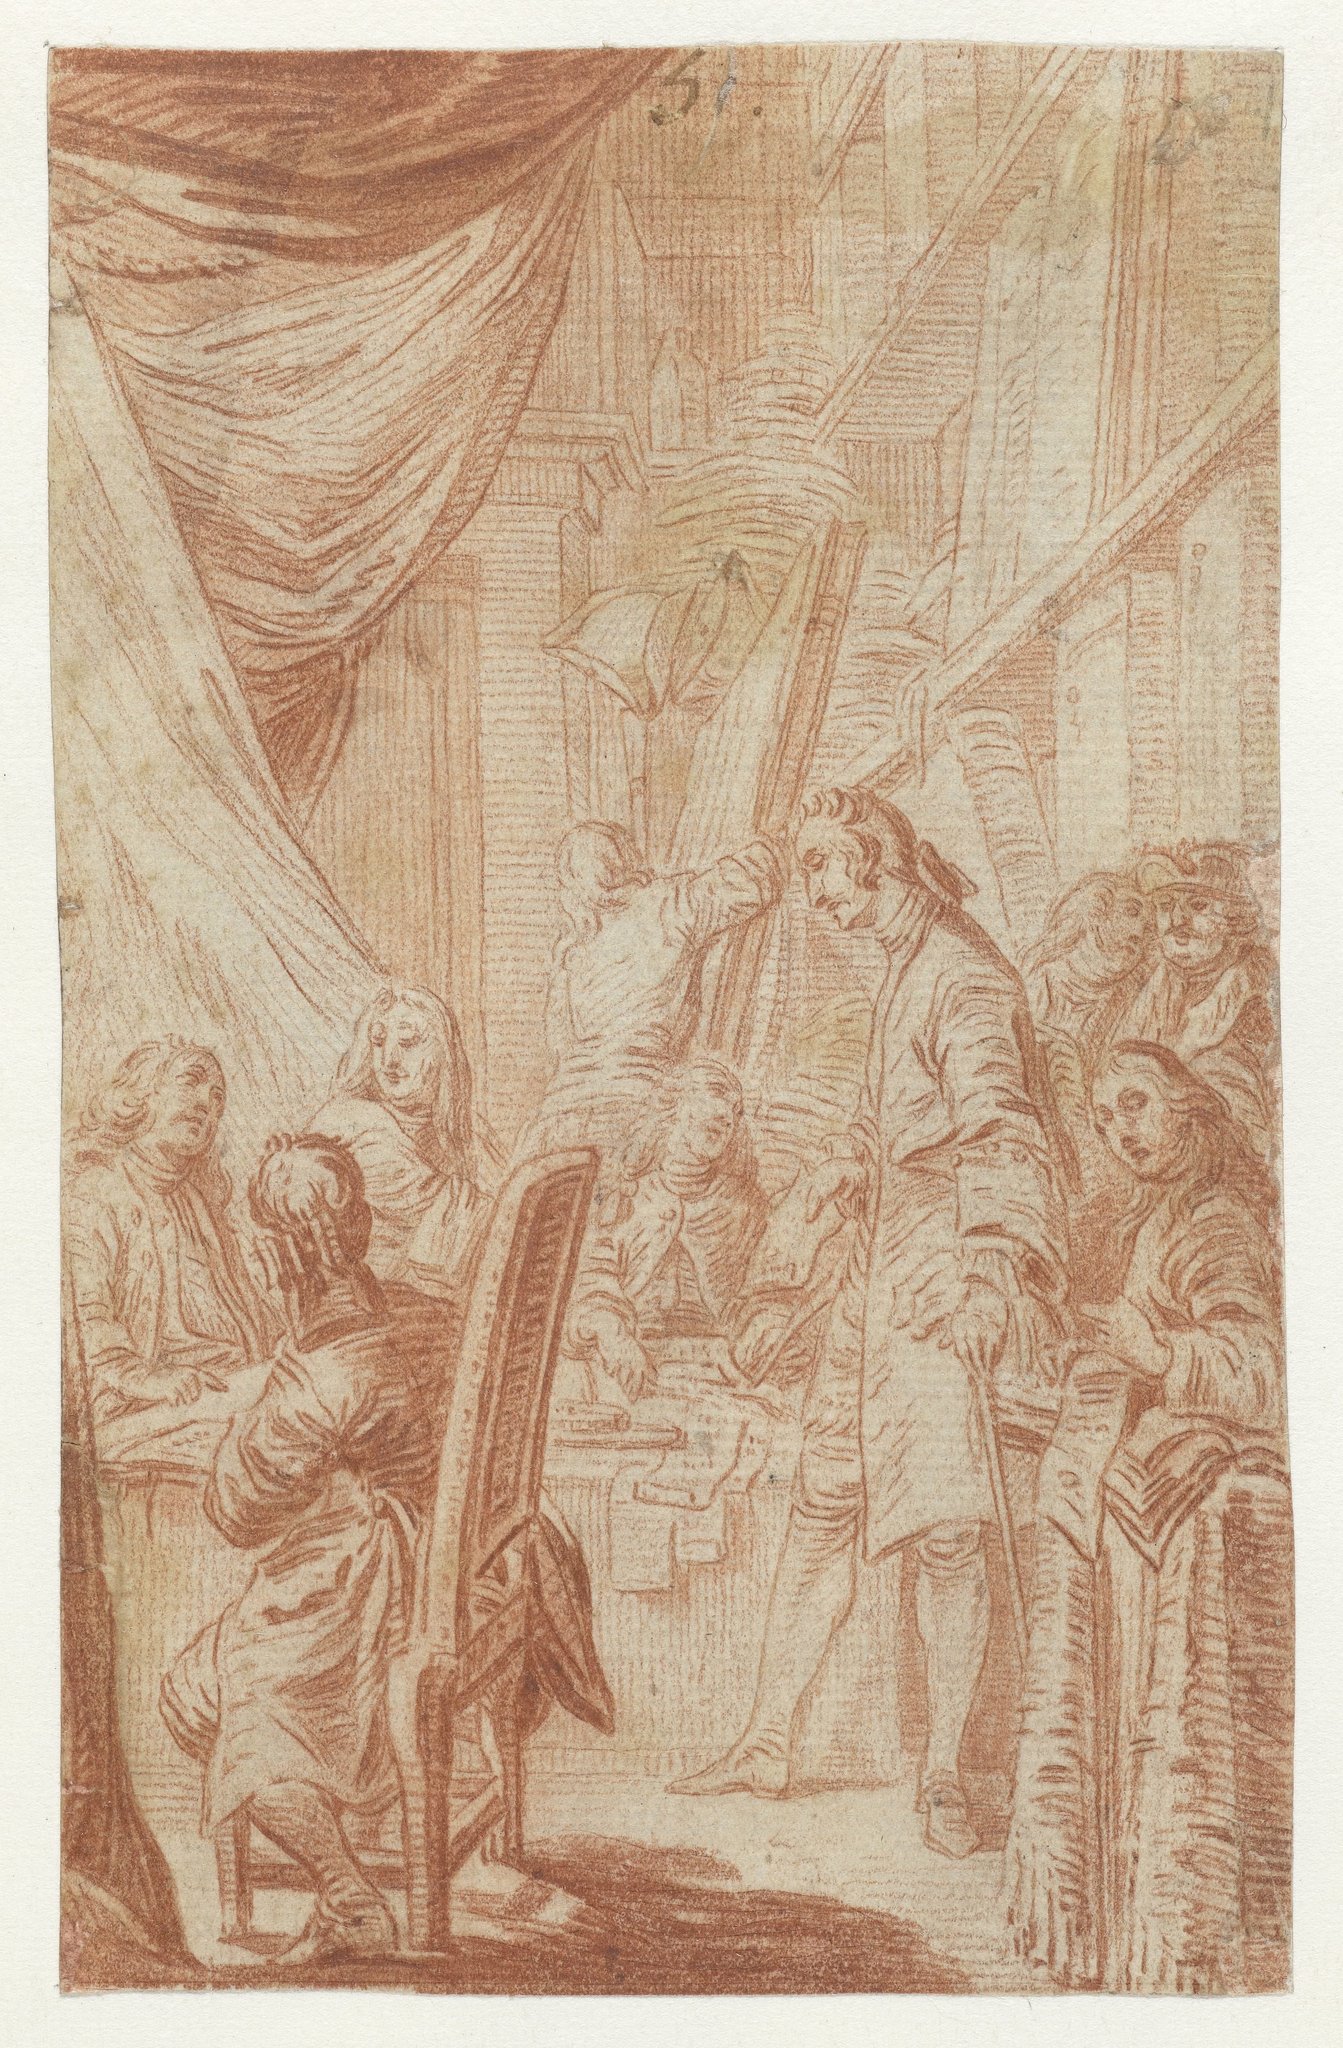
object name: drawing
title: Interieur van een notaris- of loterijkantoor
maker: charles nicolas cochin (ii)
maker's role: draughtsman, print maker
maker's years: 1715-1790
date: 1725-1790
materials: chalk, paper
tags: raffle, lottery, notary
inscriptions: annotation, recto, upper centre, pen and brown ink: ‘51. (?)’